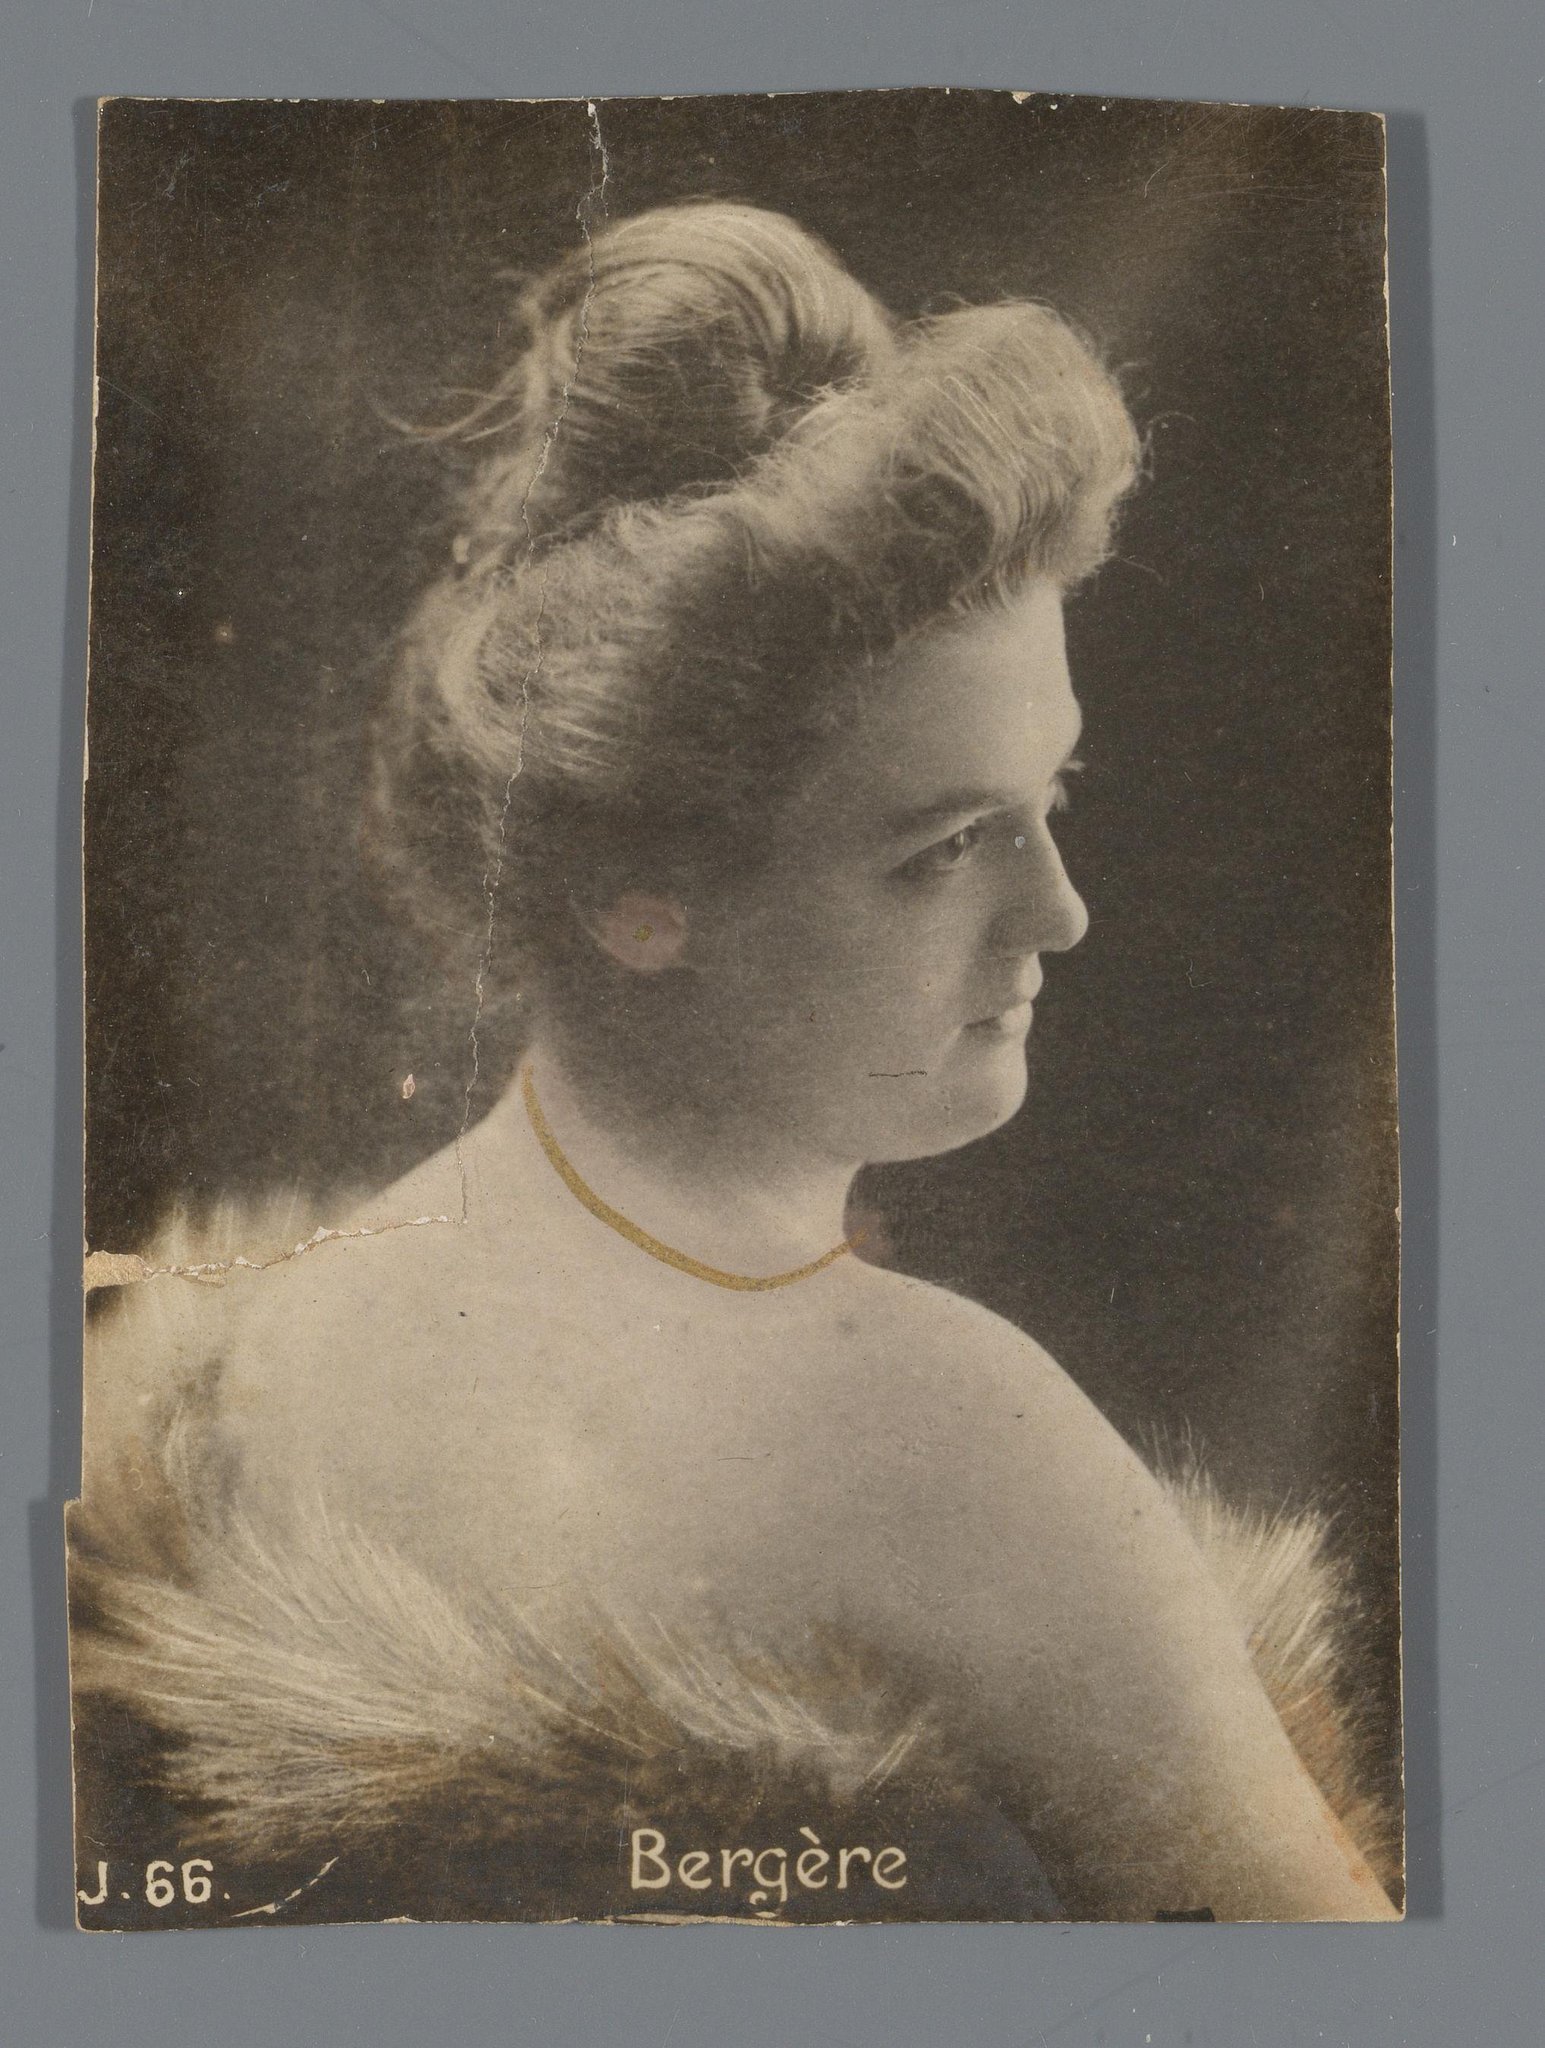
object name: photograph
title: Portret van een onbekende vrouw met opgestoken haar, aangeduid als Bergère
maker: Anonymous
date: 1890-1910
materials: photographic support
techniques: gelatin silver print, hand coloring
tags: historical persons - bb - woman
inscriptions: number: ‘J 66’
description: Dergelijke foto's stonden bekend als 'zwartjes'. Men verkreeg ze bij aanschaf van bepaalde merken thee, cacao, sigaretten, beschuit, etc. om te verzamelen. Er waren speciaal voor de 'zwartjes' vervaardigde verzamelalbums in omloop.